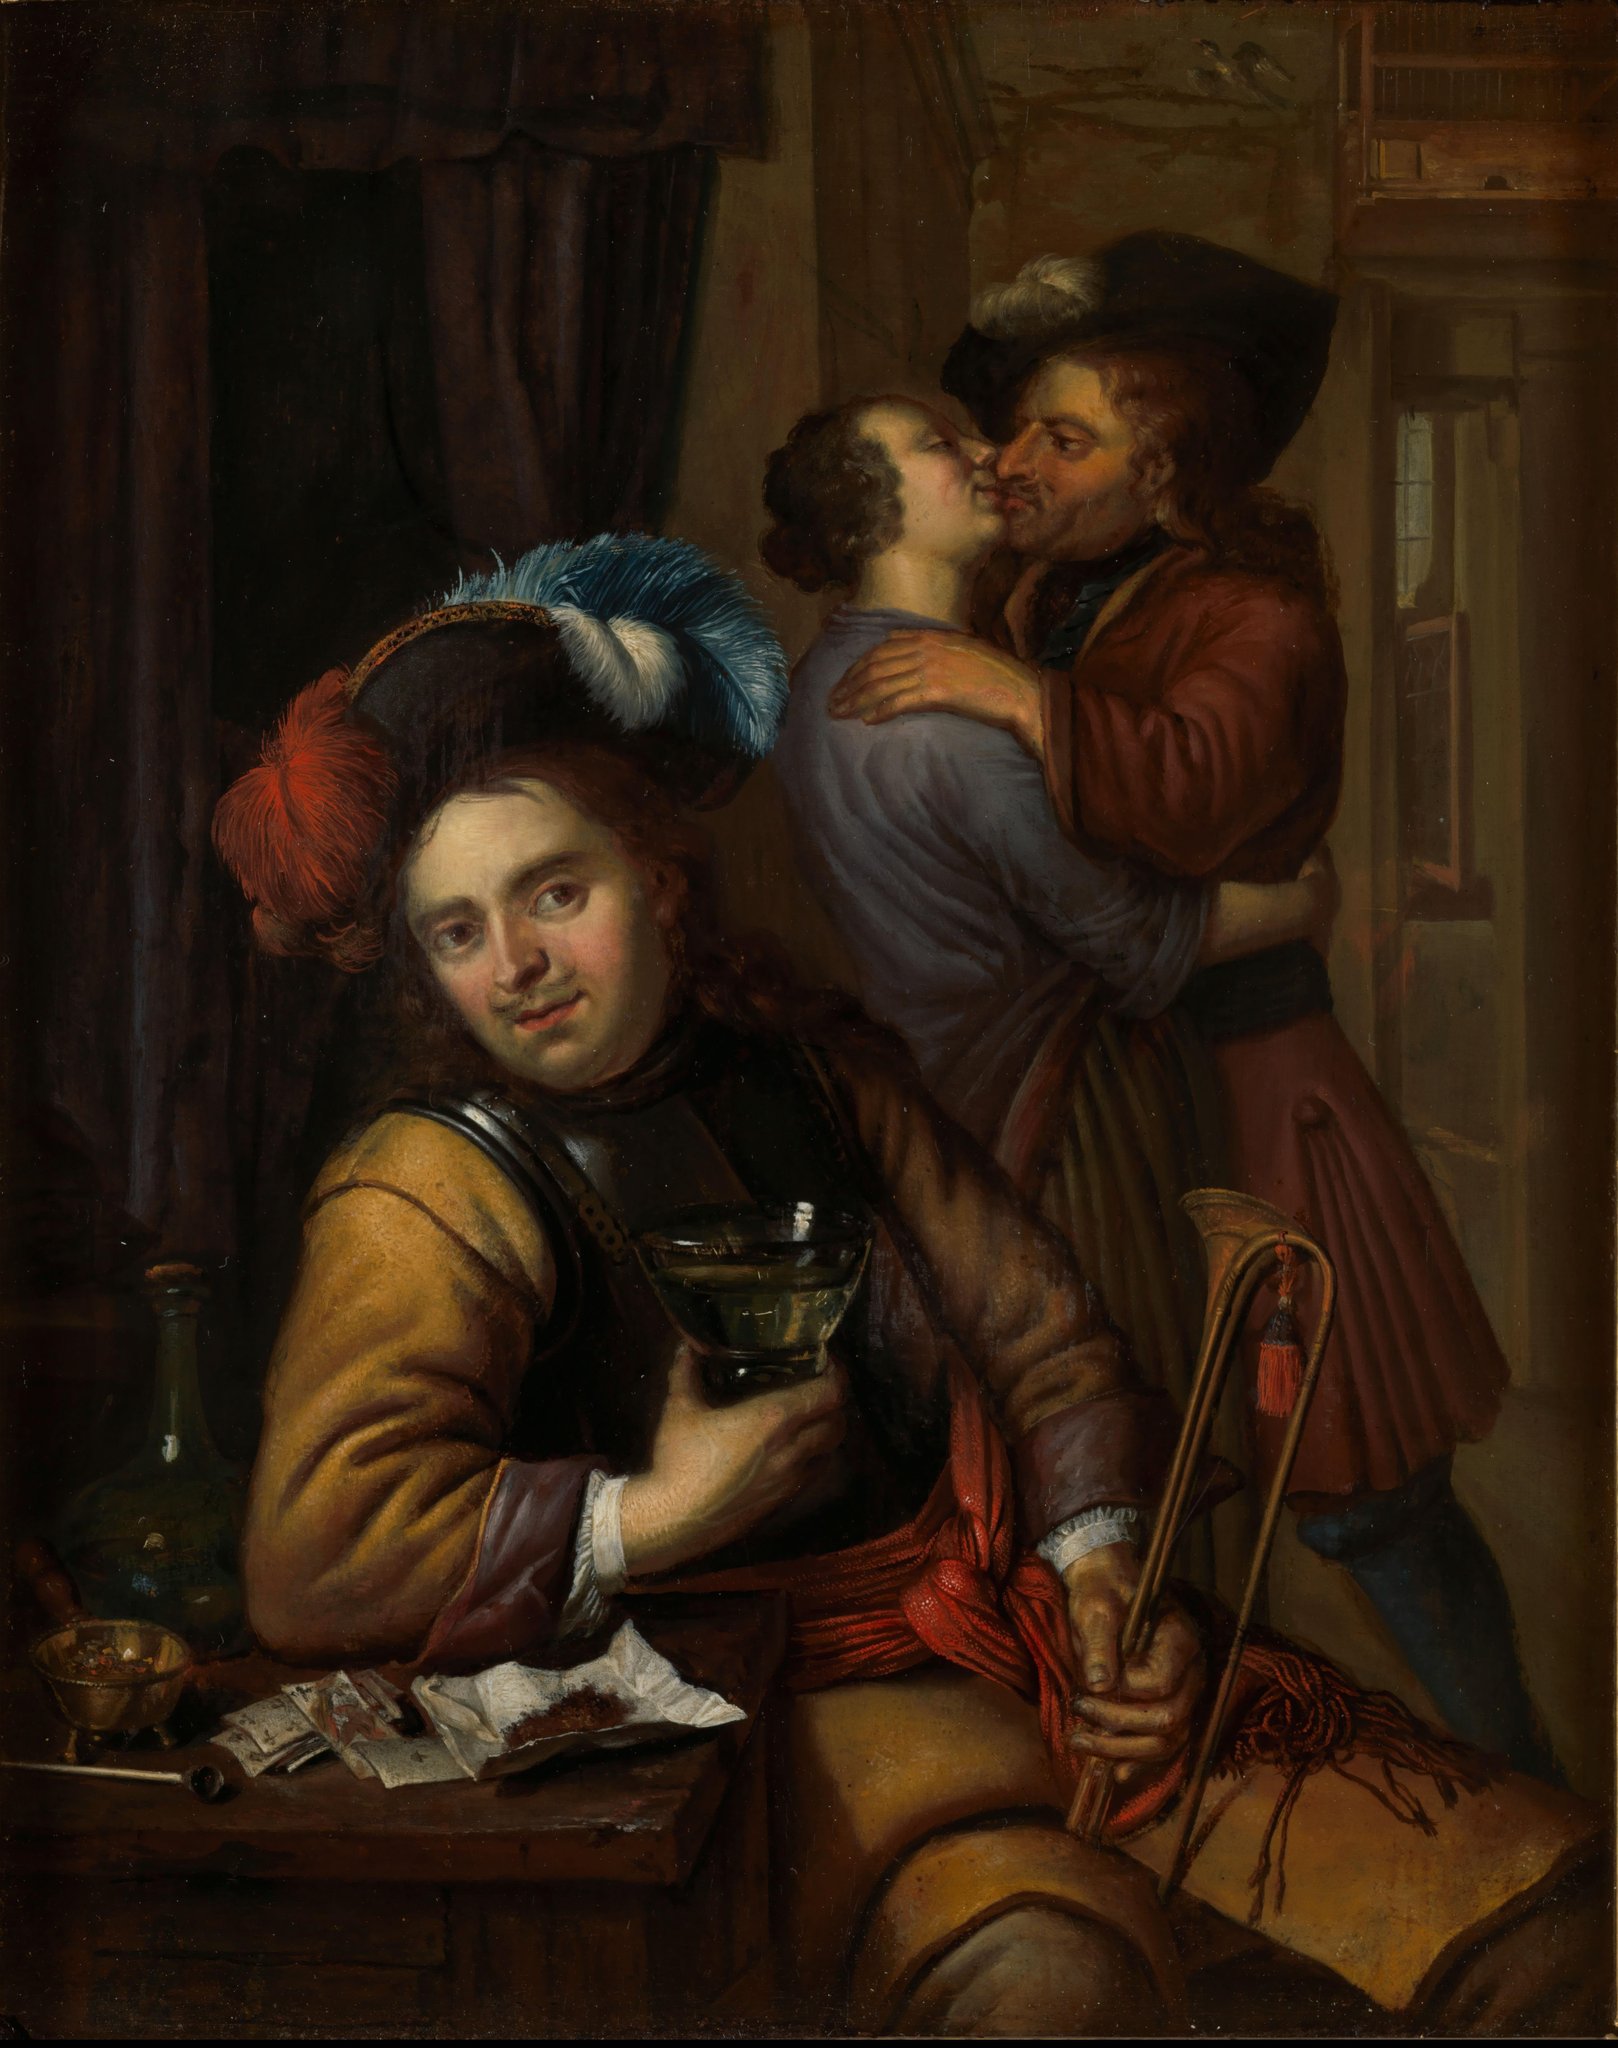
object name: painting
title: Soldier Scene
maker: carel de moor (ii)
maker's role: draughtsman, painter, print maker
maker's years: 1655-1738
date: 1680-1738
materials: oil, panel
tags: horn, trumpet, cornet, trombone, tuba, (lovers) kissing each other, pipe ~ tobacco, the soldier off duty, amorousness, desire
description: Soldatenscène. Op de voorgrond een zittende soldaat met een roemer in de rechterhand en een trompet of bazuin, tussen de benen omhoog stekend, in de linkerhand. Hij leunt op een tafel waarop een pijp, tabak, kaarten, een testje en een fles staan. Op de achtergrond kust een soldaat een vrouw.